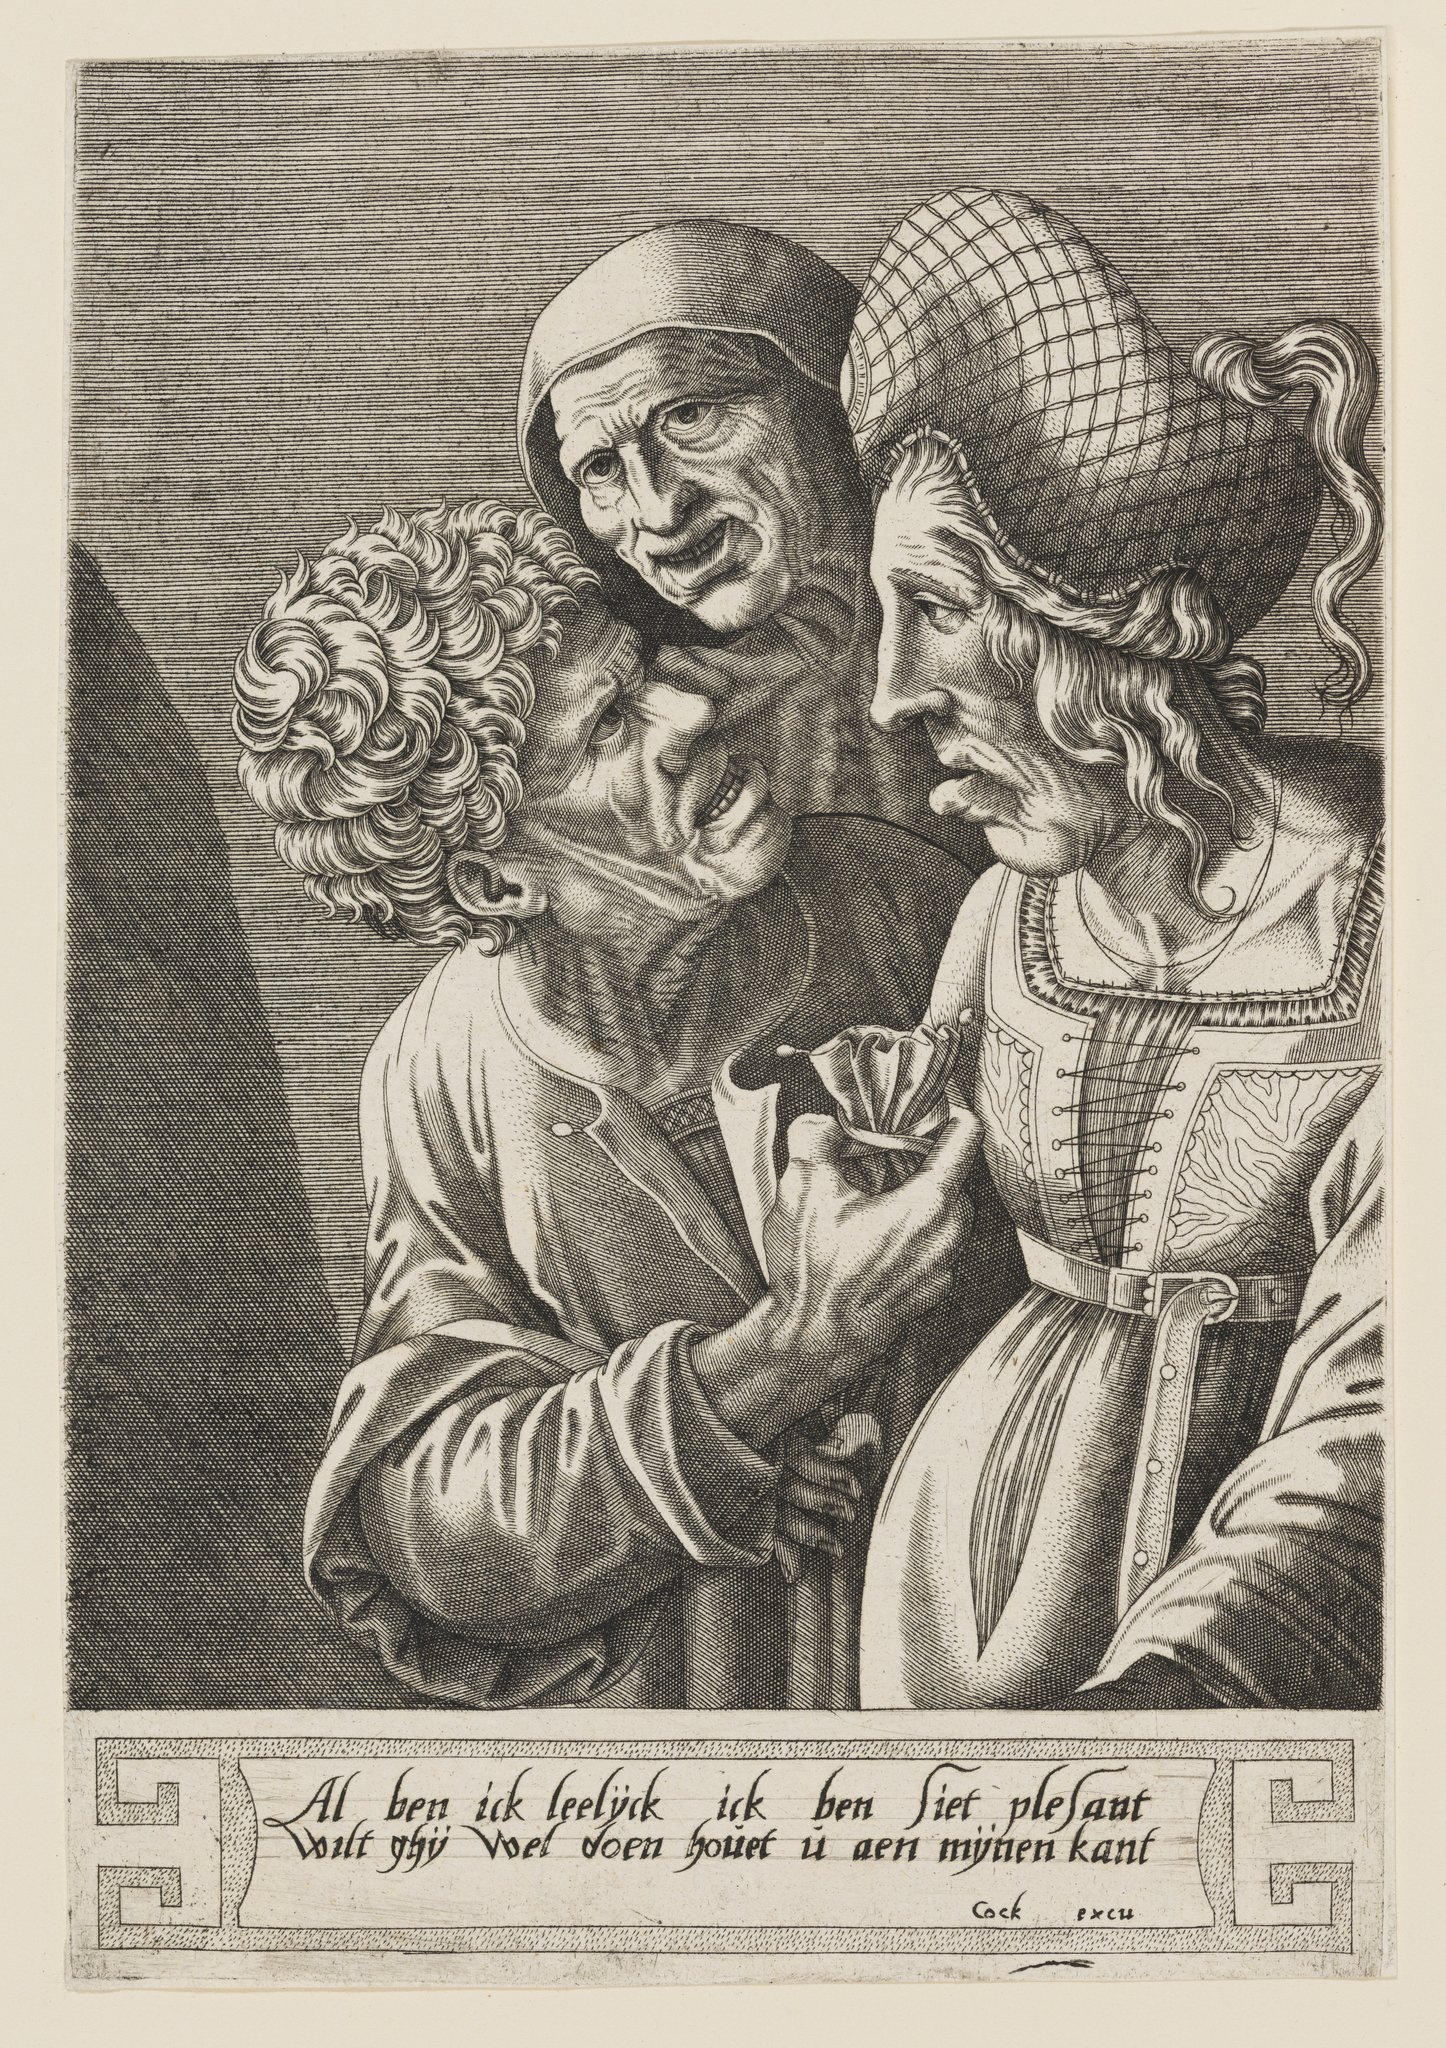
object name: print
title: A Rich Old Woman with a Suitor and a Match Maker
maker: hieronymus cock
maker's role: publisher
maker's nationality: netherlandish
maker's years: 1510-1570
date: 1530-1570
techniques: engraving